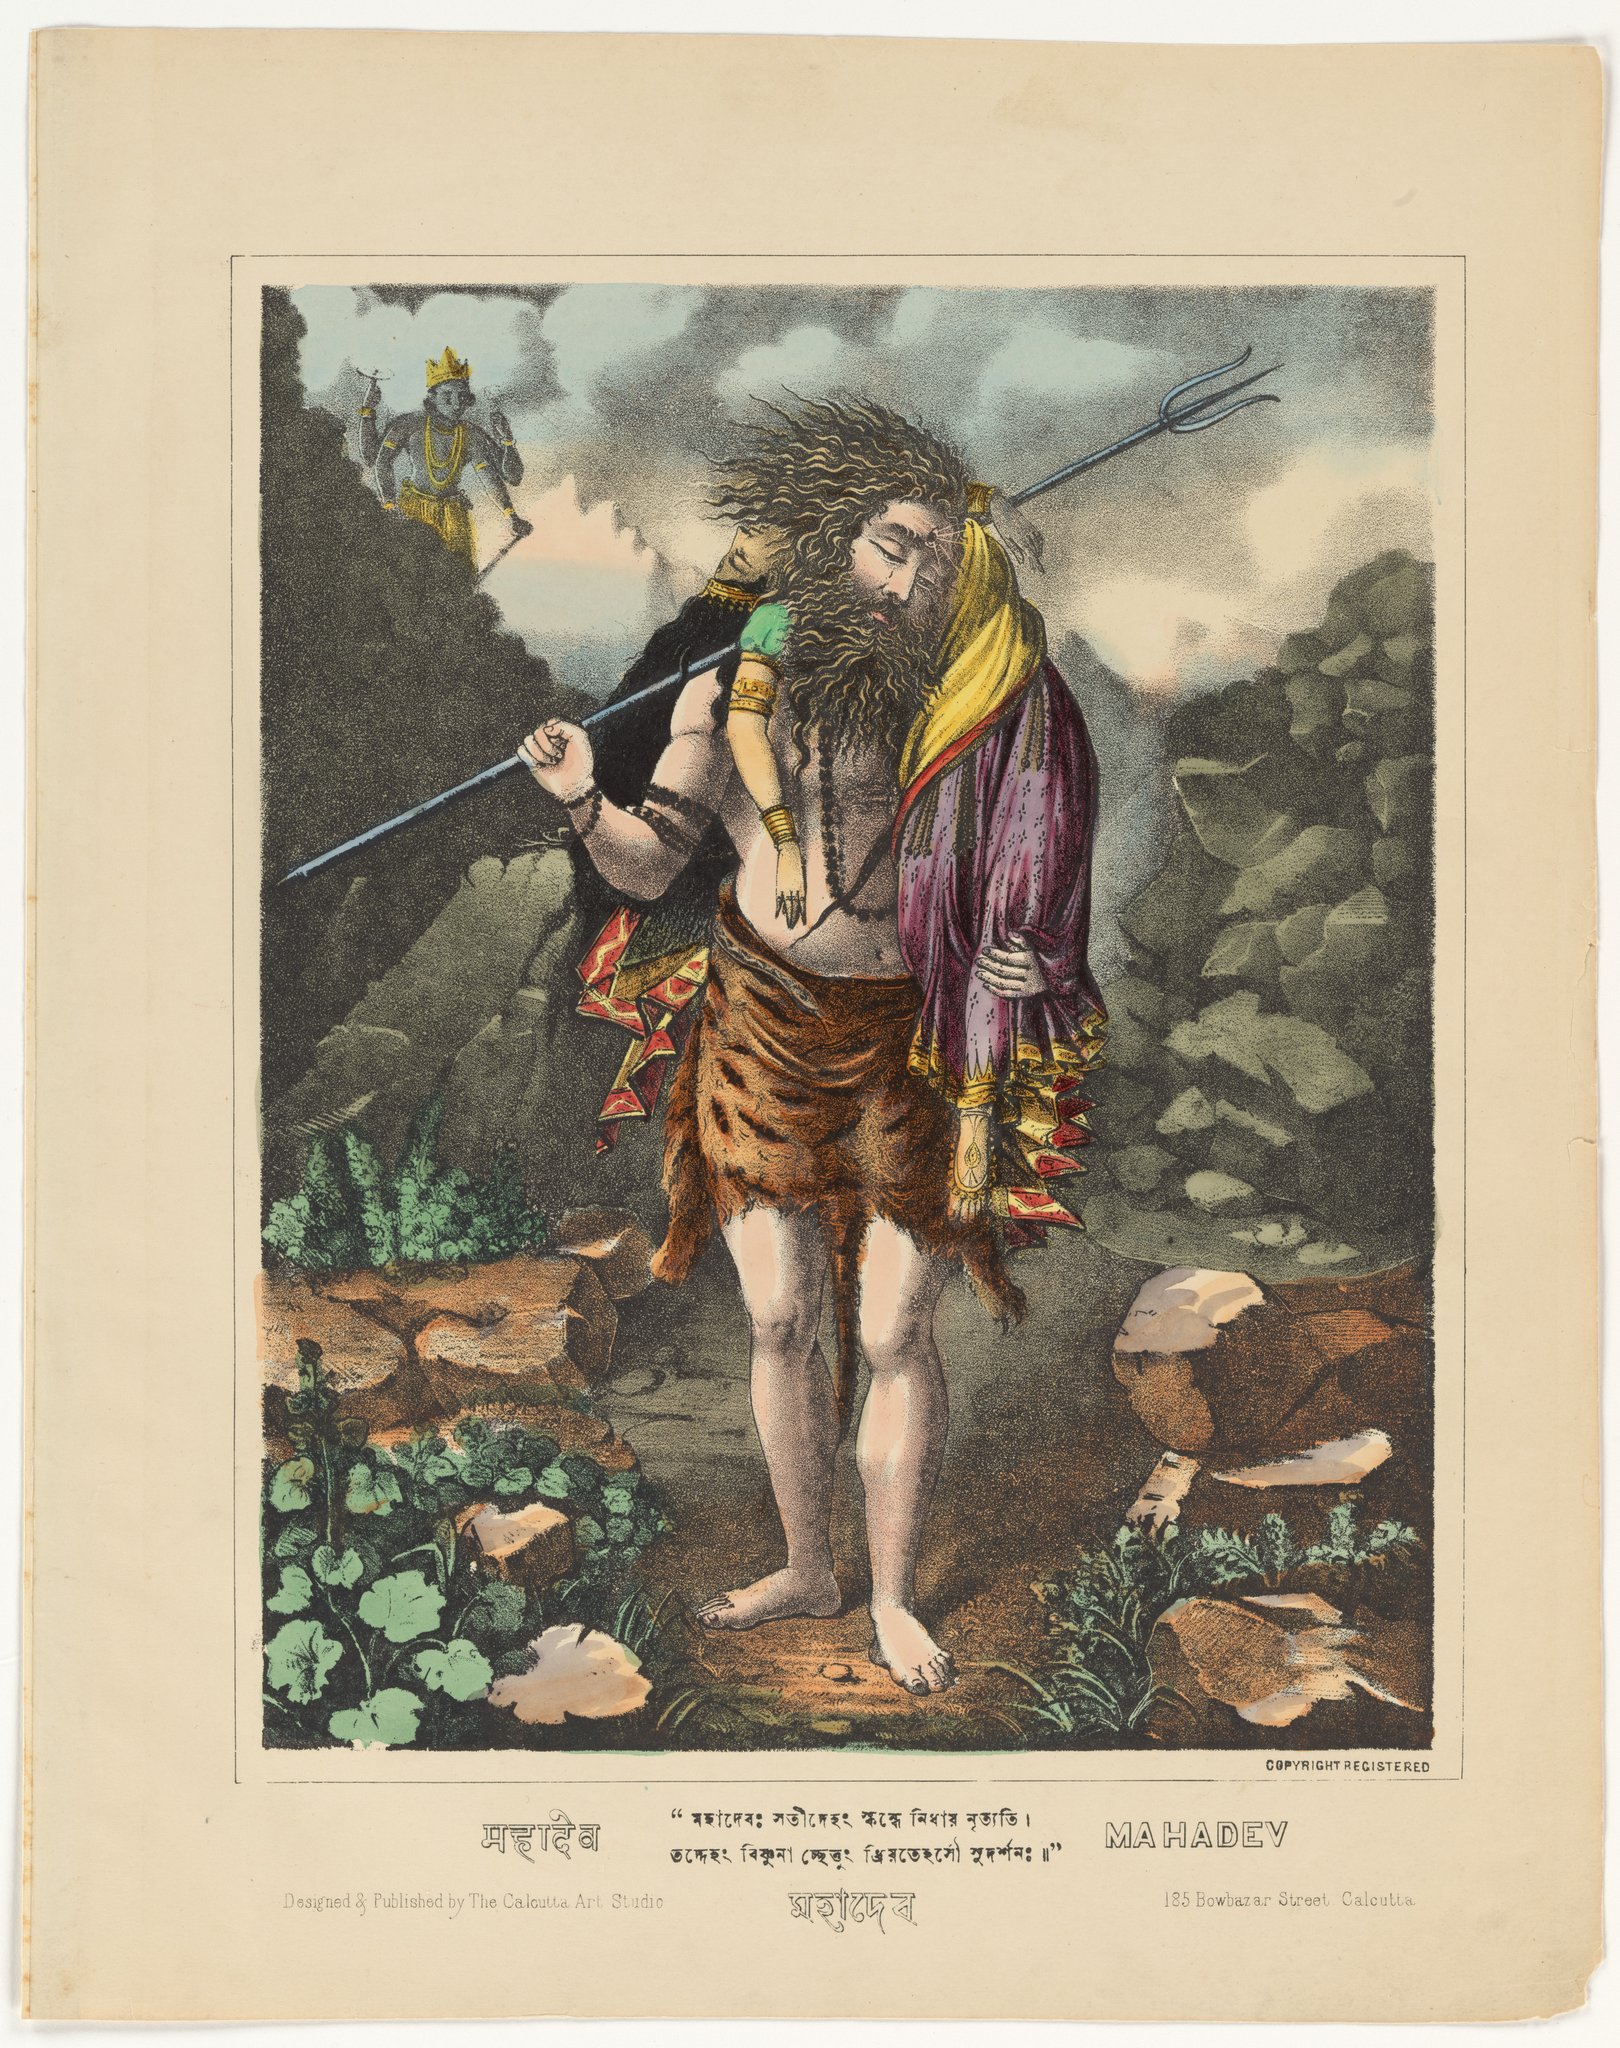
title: Shiva Mahadev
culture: west bengali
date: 1878-1883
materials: glaze, watercolor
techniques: hand coloring, lithograph, printing